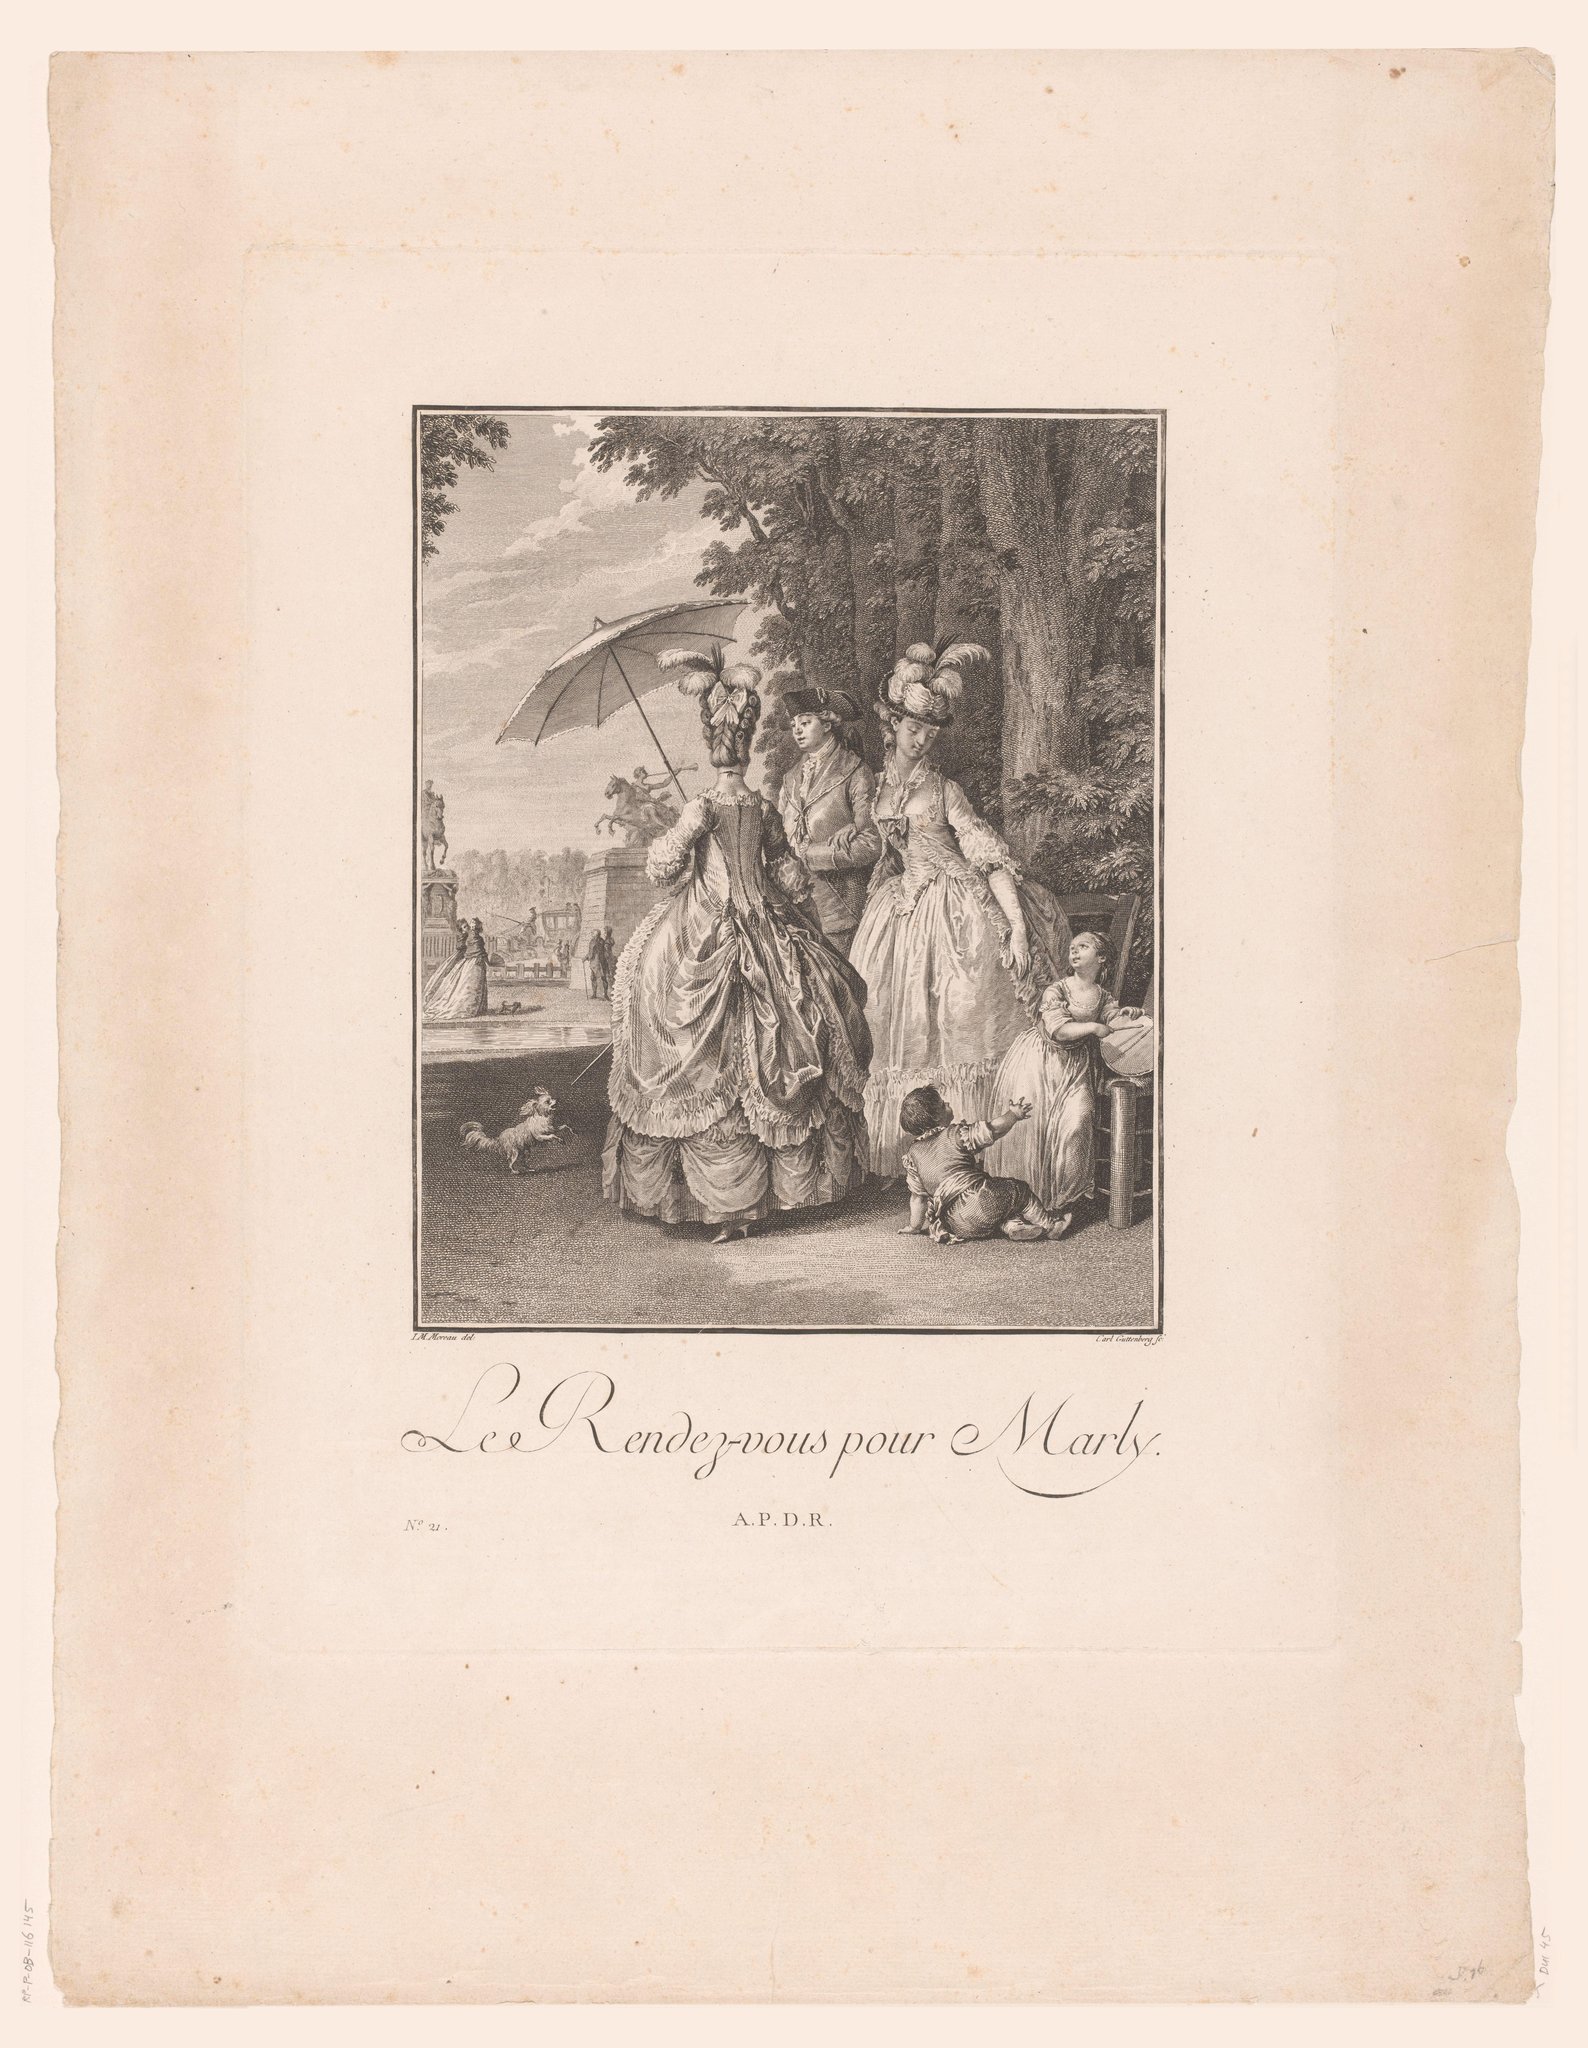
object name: costume print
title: Le Monument du Costume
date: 1776-1777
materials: paper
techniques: etching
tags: clothes, costume (+ boys' clothes), head-gear: hat (+ men's clothes), head-gear: hat (+ women's clothes), skirt (+ women's clothes), clothes, costume (+ men's clothes), walking the dog, head-gear: hat (+ feathers used for clothes), clothing for the upper part of the body (with name) (+ women's clothes), statues, sculptures in garden, arm in arm (lovers), drum (musical instrument) - cc - out of doors (+ variant), parasol, sunshade (+ women's clothes), dress, gown (+ girls' clothes), dress, gown: robe à la polonaise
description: This series of plates centres on the fashion, interiors and etiquette of the wealthy French elite around 1776. We follow a young lady du bon ton (of good taste) from the time of her pregnancy until her return to society life. At home, she is shown in a negligée 1 2 3. For a horseback ride in the Bois de Boulogne, she chooses an Amazonian riding outfit 4, and when paying a visit to Marly, the king’s country residence, she dons a robe à la polonaise 5. The opera demands a robe à la française, with a skirt so wide that she can pass through doorways only sideways 6.